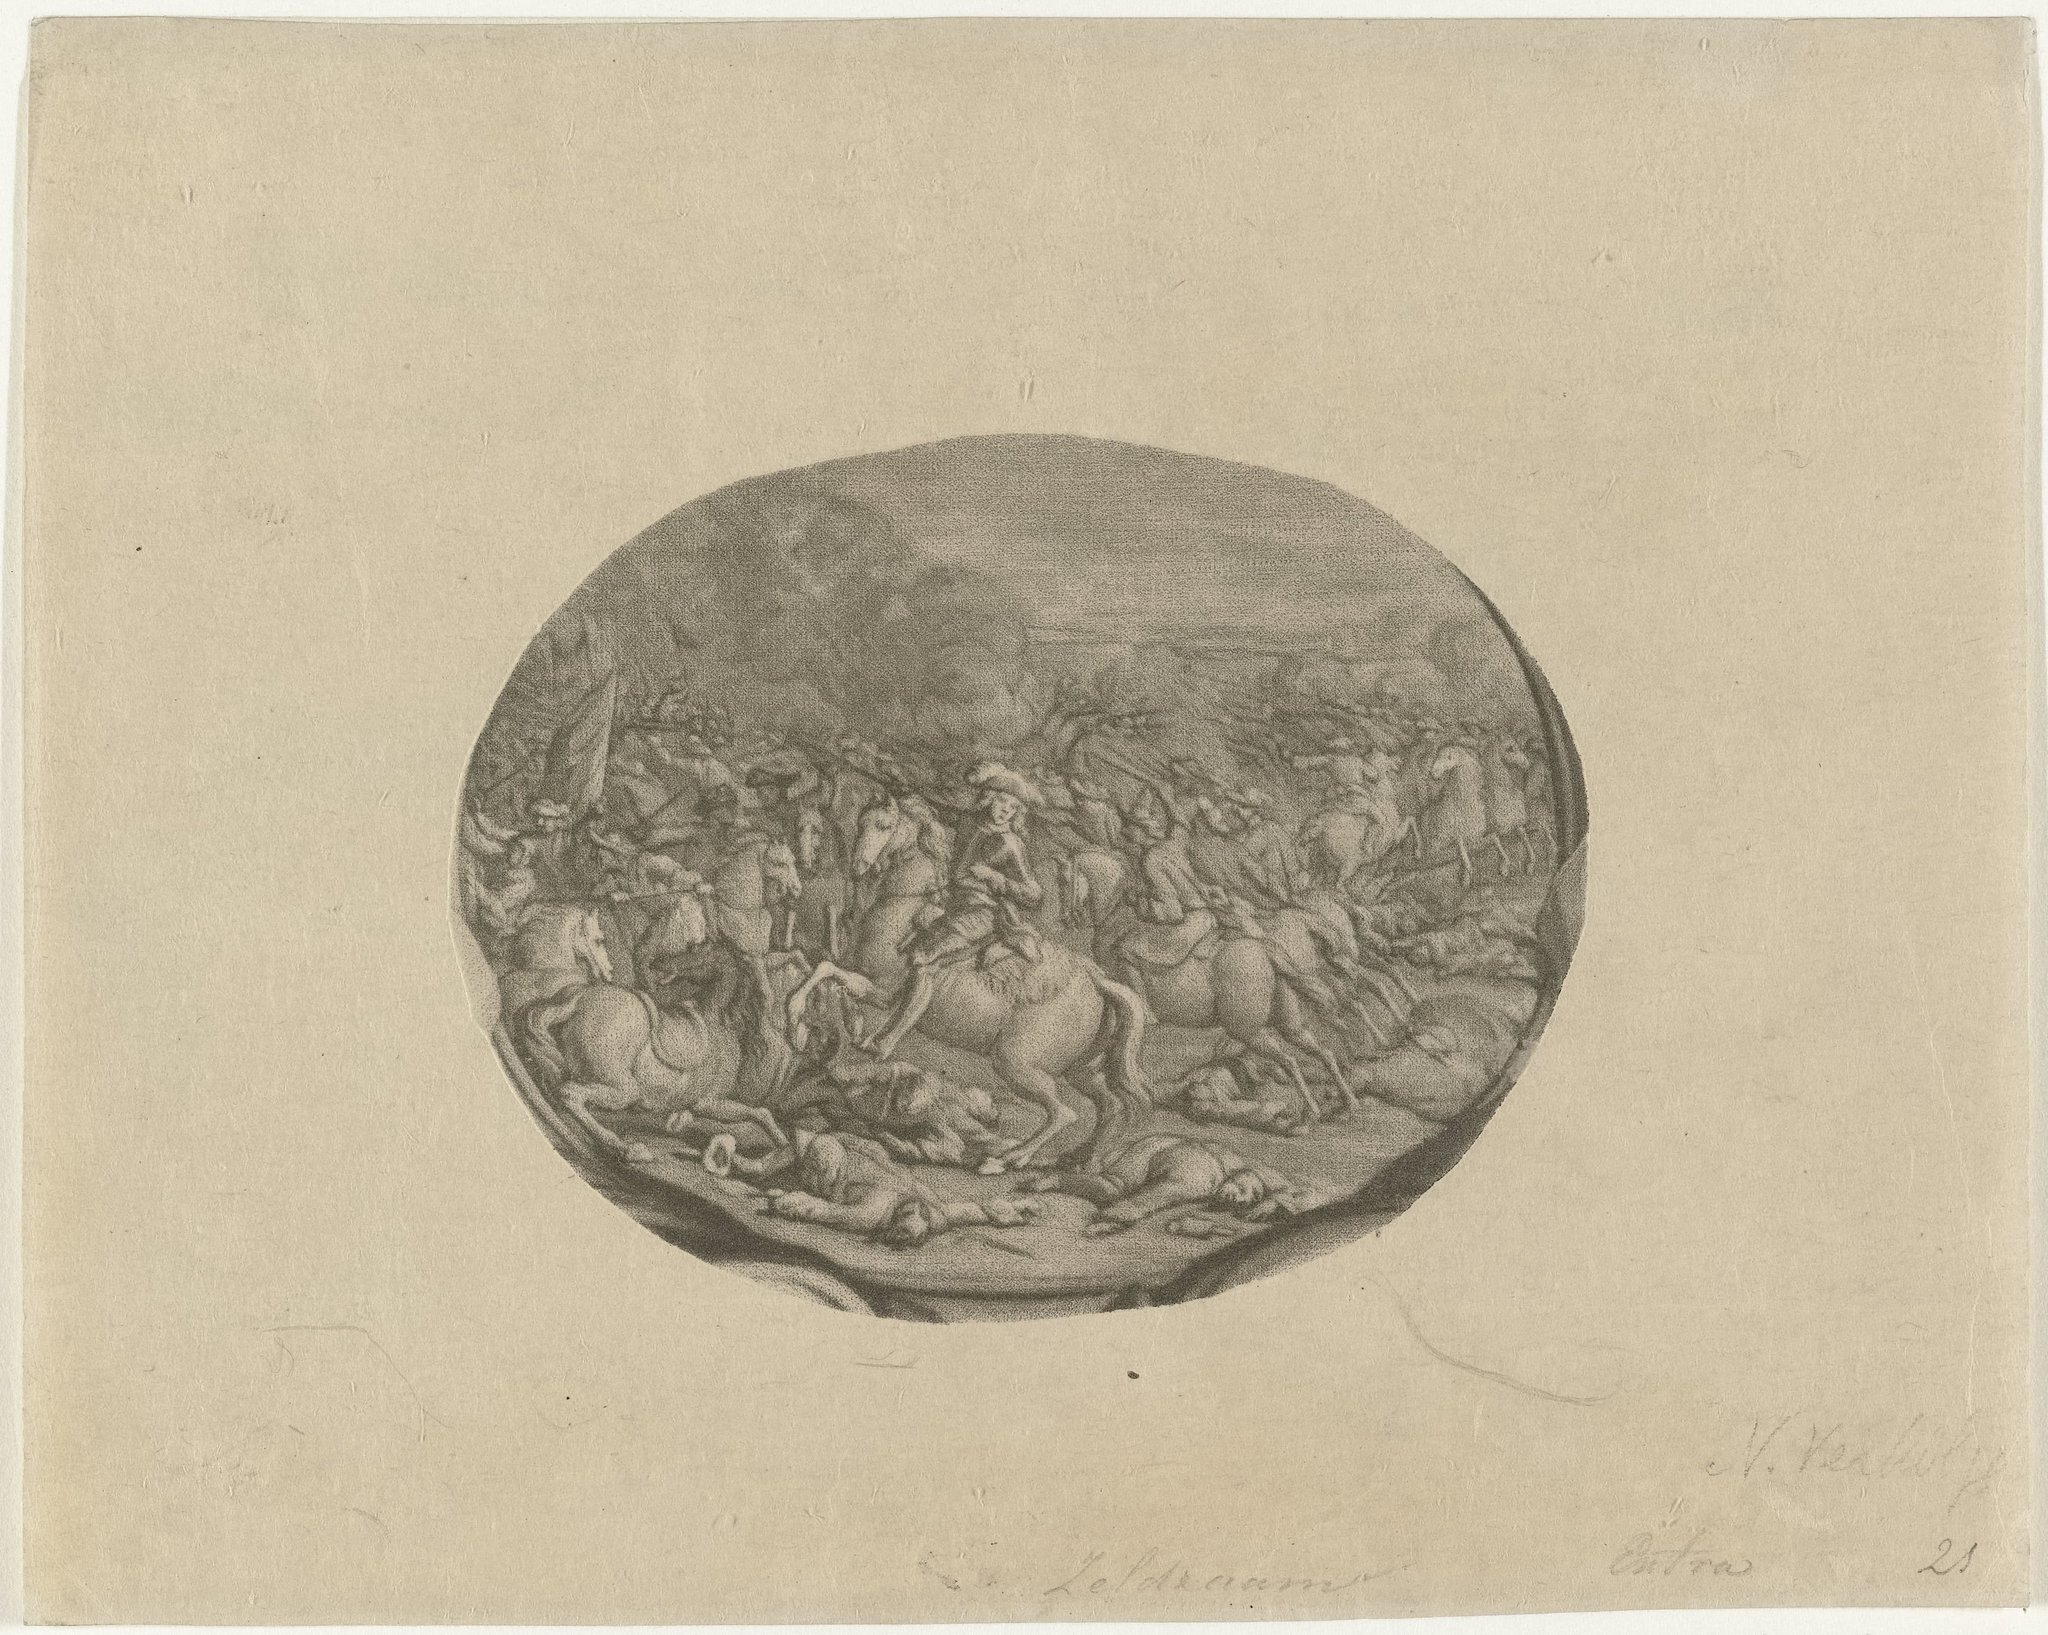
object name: print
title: Vignet met een afbeelding van de slag bij Kalisch (29-10-1706), afkomstig uit het portret van Frederik Augustus II, hertog van Saksen en koning van Polen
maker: nicolaas verkolje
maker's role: draughtsman, painter, print maker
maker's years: 1673-1746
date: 1706-1746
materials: paper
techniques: mezzotint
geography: amsterdam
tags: battle (+ land forces)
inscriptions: collector's mark: Lugt 240